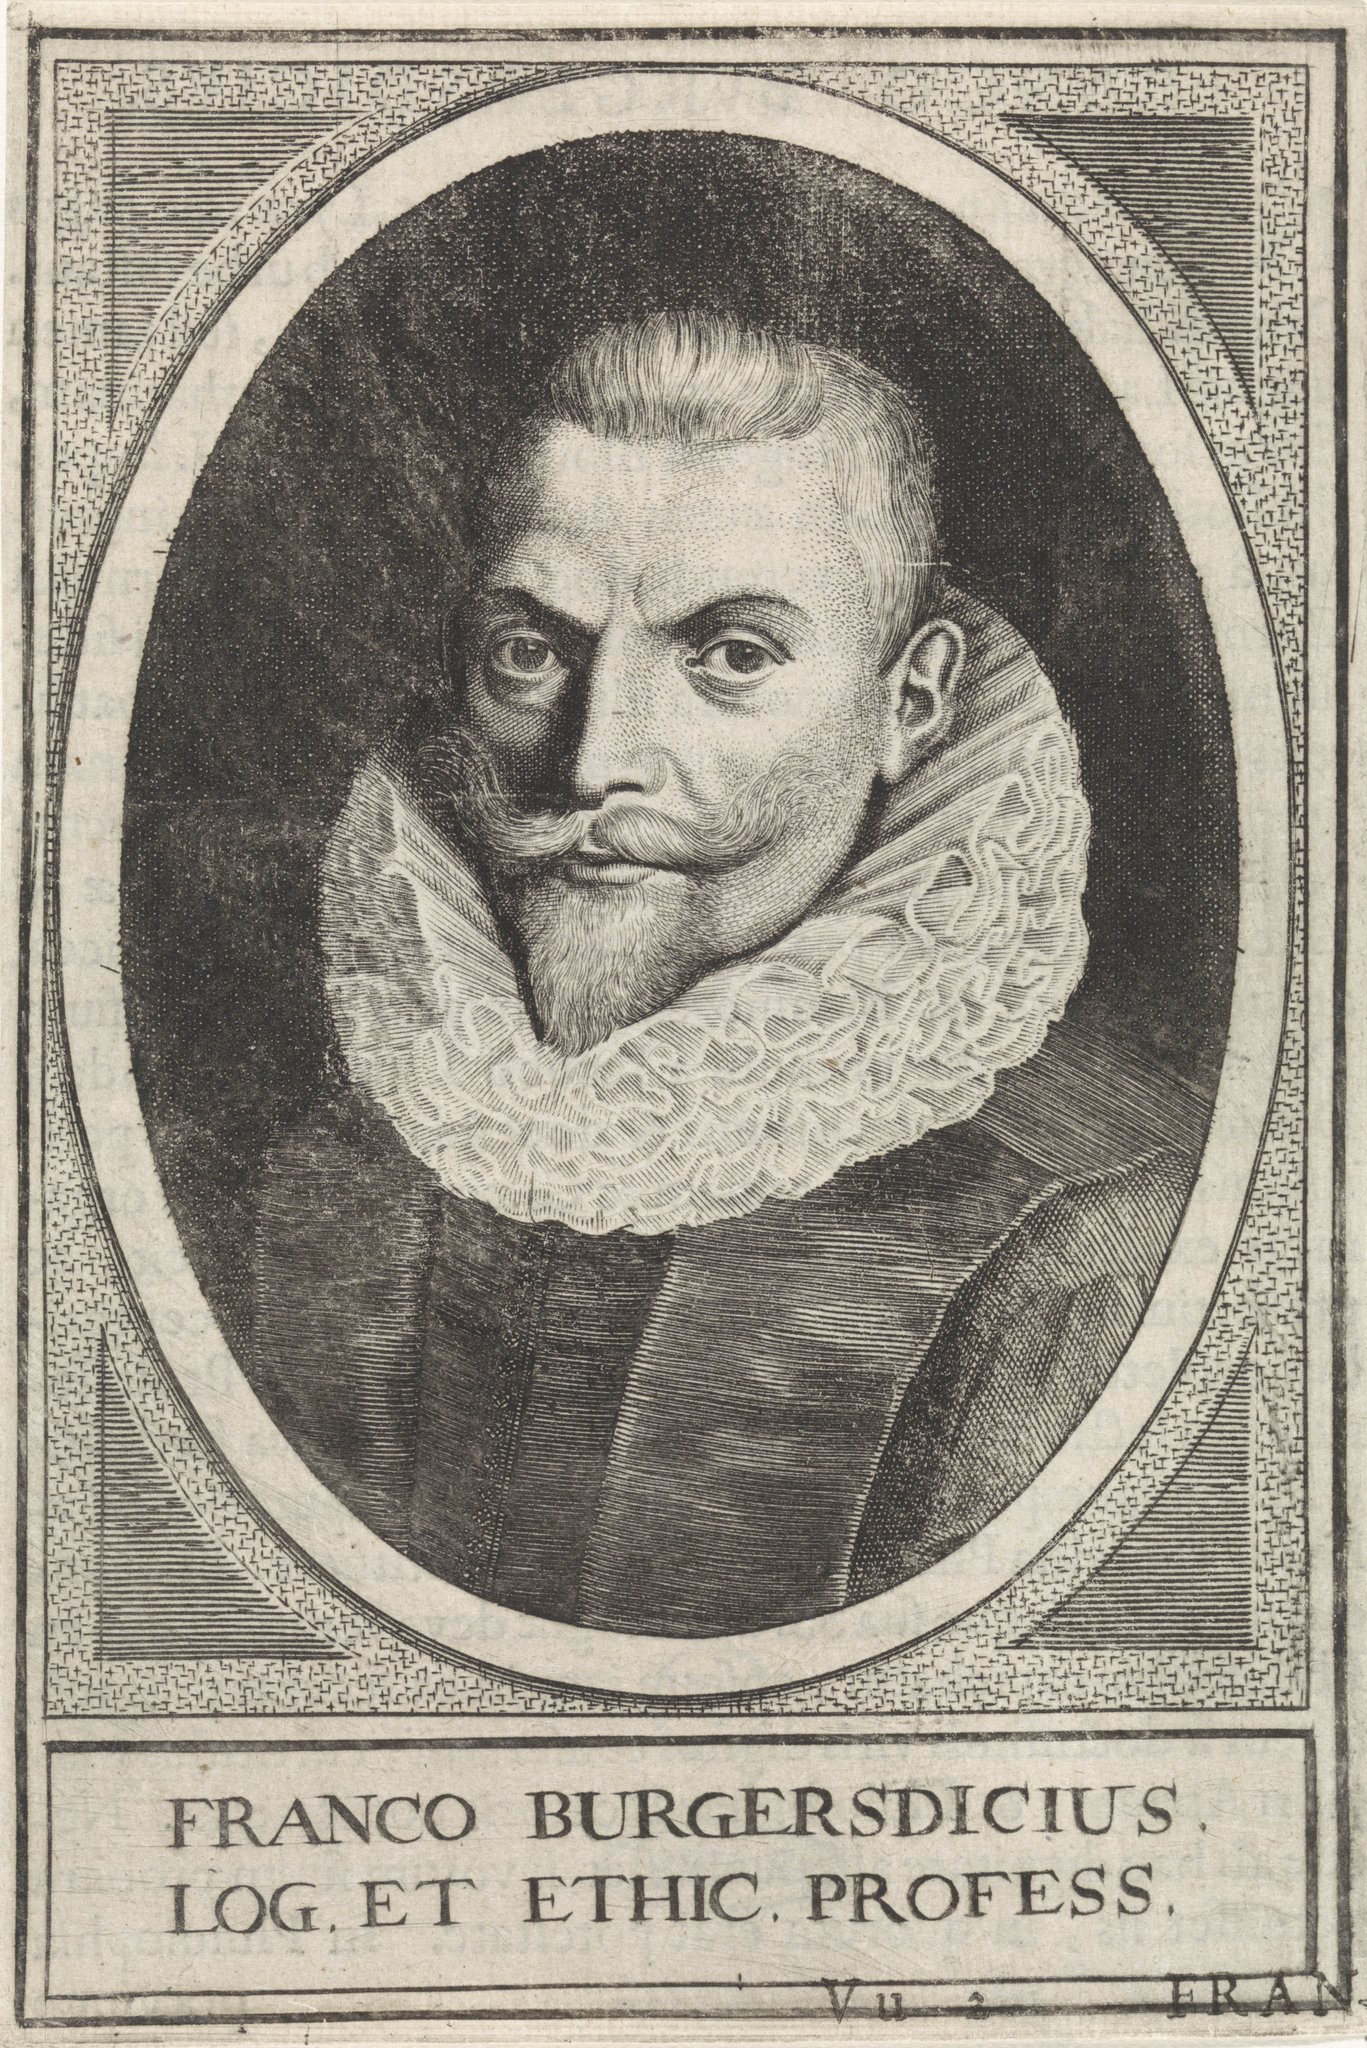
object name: print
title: Portret van Franco Petri Burgersdijck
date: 1625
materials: paper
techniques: engraving, letterpress printing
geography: leiden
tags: leiden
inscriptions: collector's mark: Lugt 964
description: Boekillustratie in: Meursius, Joannes. Athenæ Batavæ. Sive, De vrbe Leidensi, & academiâ, virisque claris. Leiden: Andries Clouck, Bonaventura en Abraham Elzevier, 1625. Abusievelijk tweemaal gecatalogiseerd bij Franken & Van der Kellen.